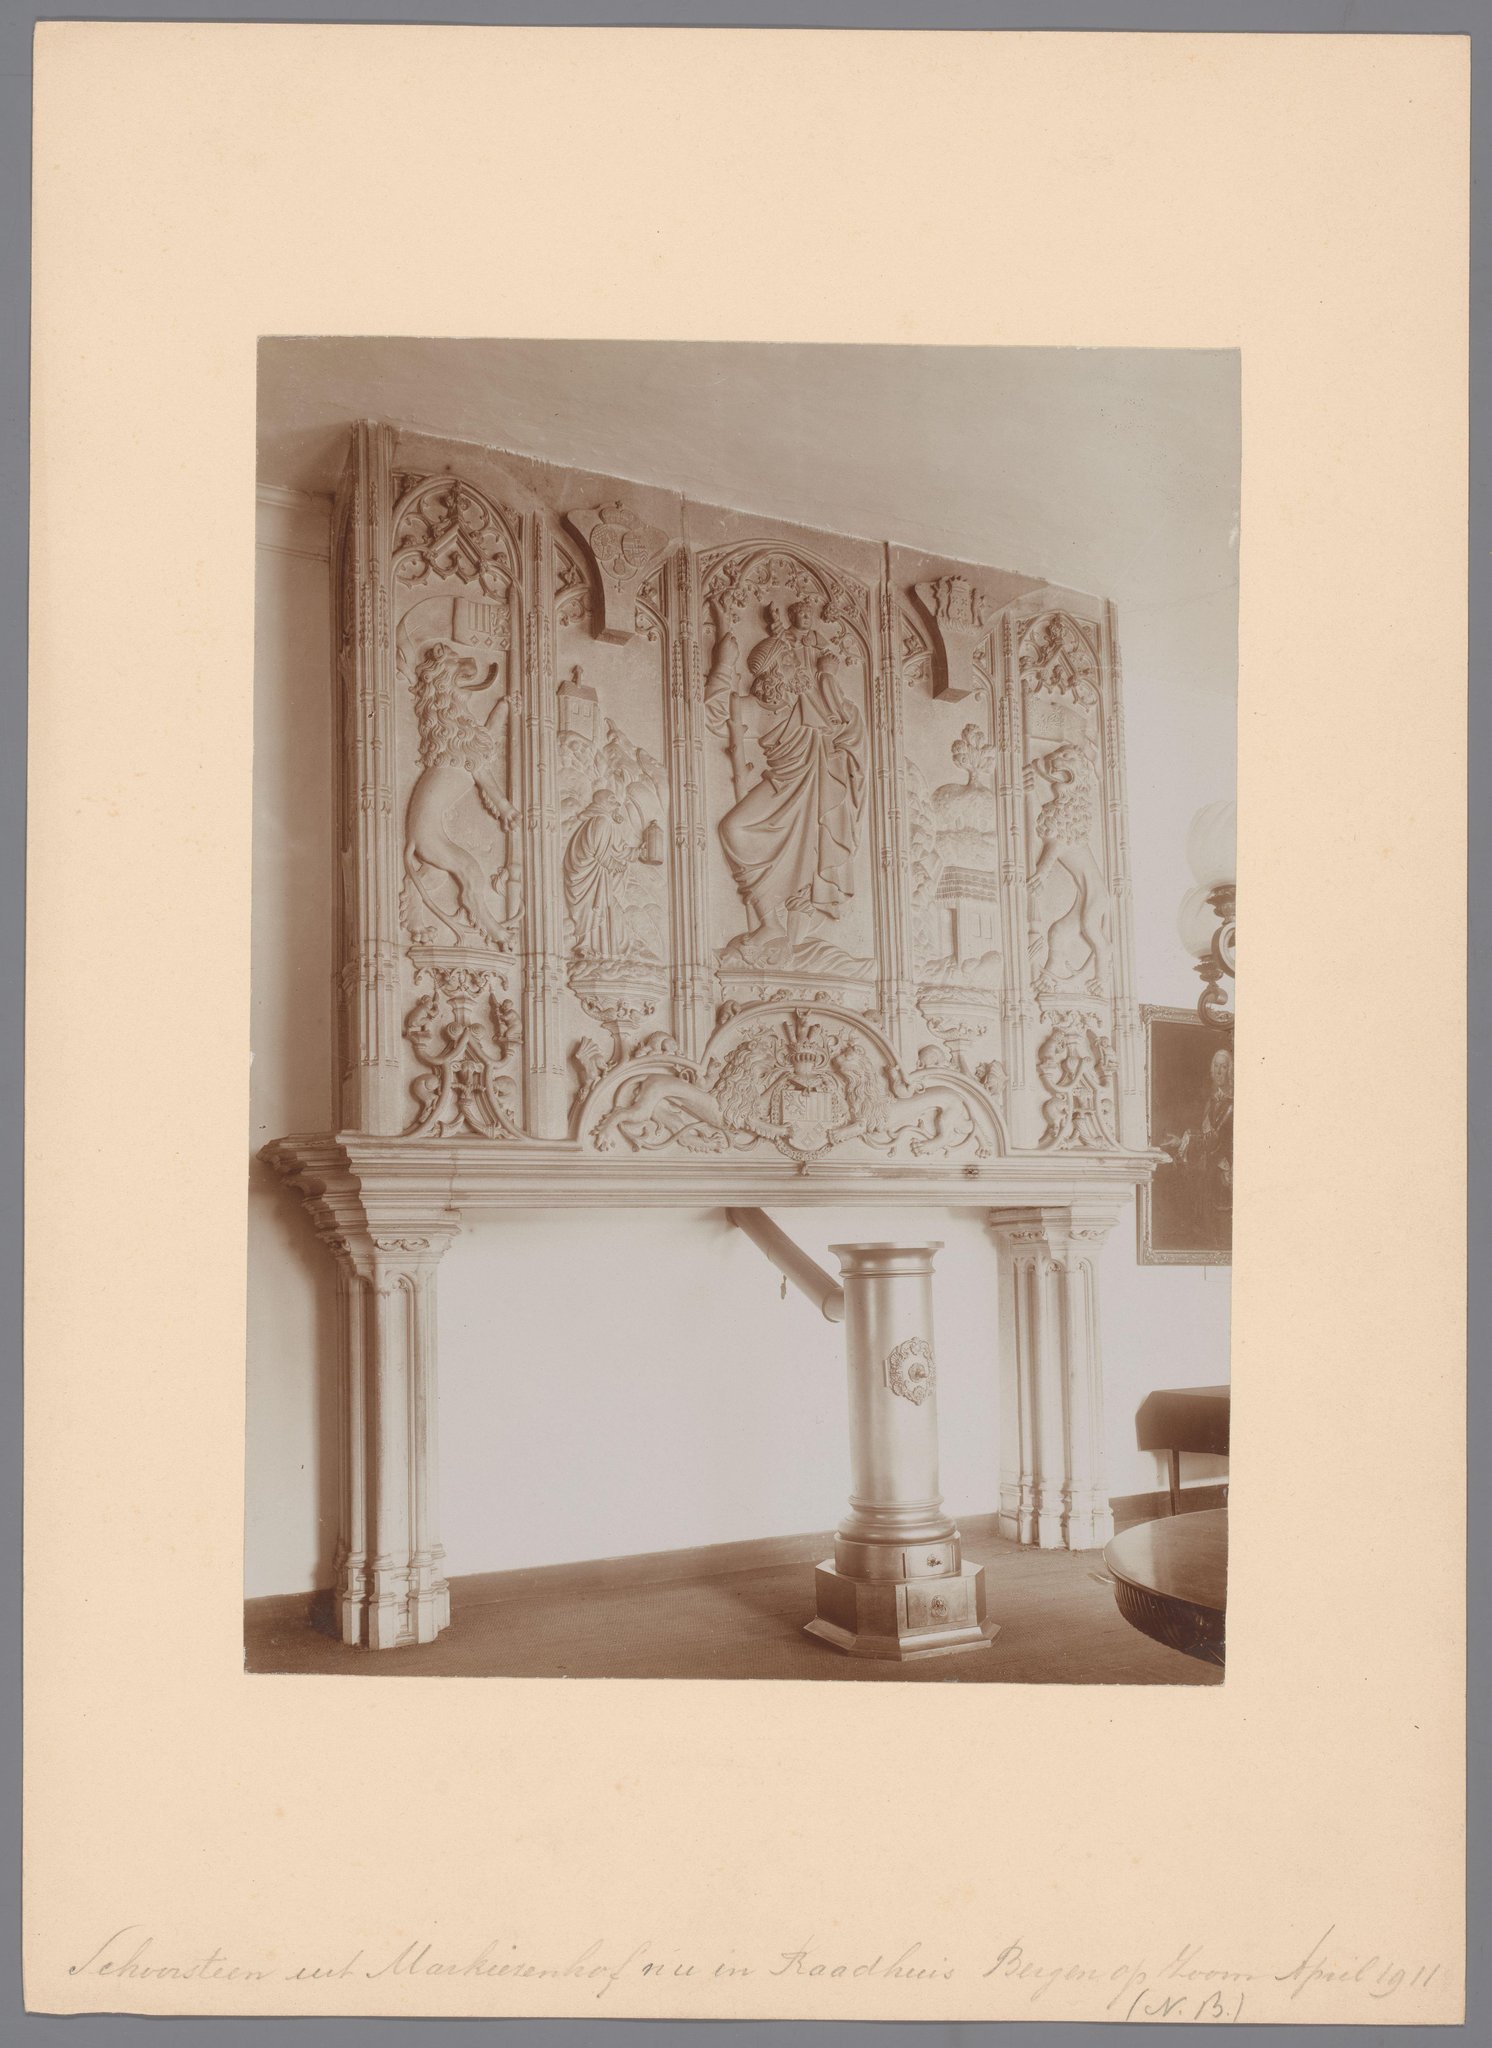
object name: photograph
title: Schoorsteen met reliëf in het stadhuis te Bergen op Zoom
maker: anoniem (monumentenzorg)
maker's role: fotograaf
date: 1911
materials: cardboard, photographic support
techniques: collodion silver print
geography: bergen op zoom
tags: townhall, chimney-piece, mantelpiece, sculpture (+ relief ~ sculpture)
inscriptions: annotation: ‘Schoorsteen uit Markiezenhof nu in Raadhuis Bergen op Zoom (N.B.) April 1911’